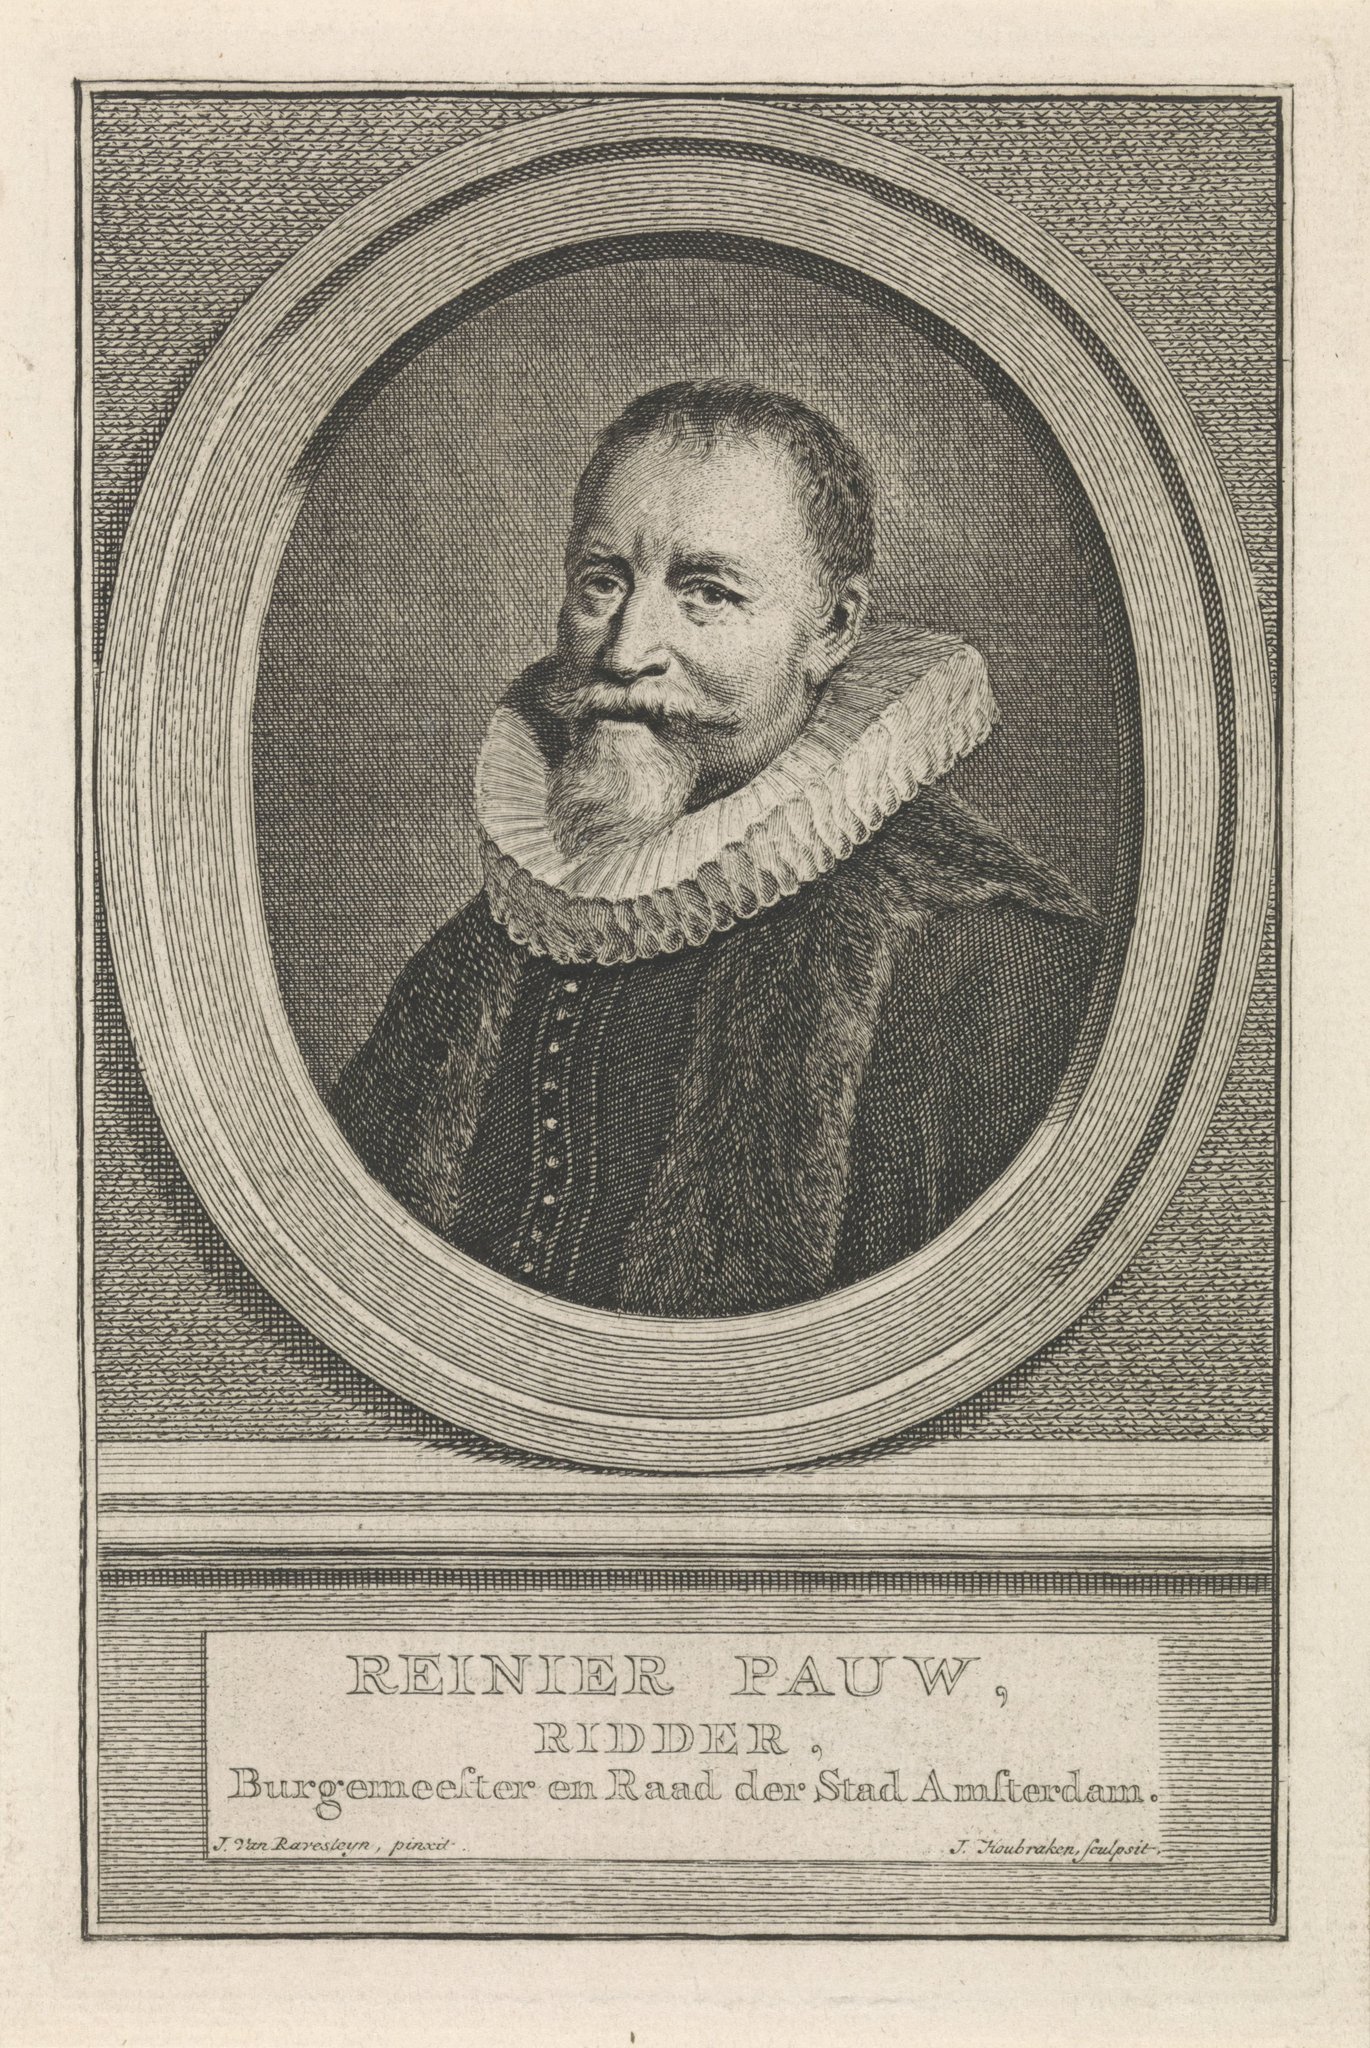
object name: print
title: Portret van Reinier Adriaensz. Pauw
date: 1749-1780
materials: paper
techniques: engraving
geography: amsterdam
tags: historical persons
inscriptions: collector's mark: Lugt 2228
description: Deze prent is oorspronkelijk bedoeld als aanvulling op Jan Wagenaars ‘Vaderlandsche historie’* en was zo vanaf 1796 verkrijgbaar bij Johannes Allart te Amsterdam. Voor de advertentie waarin Allart de 60 portretten en 7 platen, allen gegraveerd door Houbraken, ter aanvulling op Wagenaars ‘Vaderlandsche historie’ aanbiedt, zie RP-P-OB-77.766. *Van dit werk zijn in de achttiende eeuw meerdere uitgaves verschenen, zoals: Wagenaar, Jan. Vaderlandsche historie, vervattende de geschiedenissen der Vereenigde Nederlanden (…). 21 delen. Amsterdam: Isaak Tirion, 1749-1759. Wagenaar, Jan. Vaderlandsche historie, vervattende de geschiedenissen der nu Vereenigde Nederlanden (…). 21 delen. Amsterdam: weduwe Isaak Tirion, 1770. Wagenaar, Jan. Vaderlandsche historie, vervattende de geschiedenissen der nu Vereenigde Nederlanden (…). 21 delen. Amsterdam, Leiden, Dordrecht en Harlingen: P. Schouten e.a., 1782. Wagenaar, Jan. Vaderlandsche historie, vervattende de geschiedenissen der nu Vereenigde Nederlanden (…). 21 delen. Amsterdam: Johannes Allart, 1790-1796.